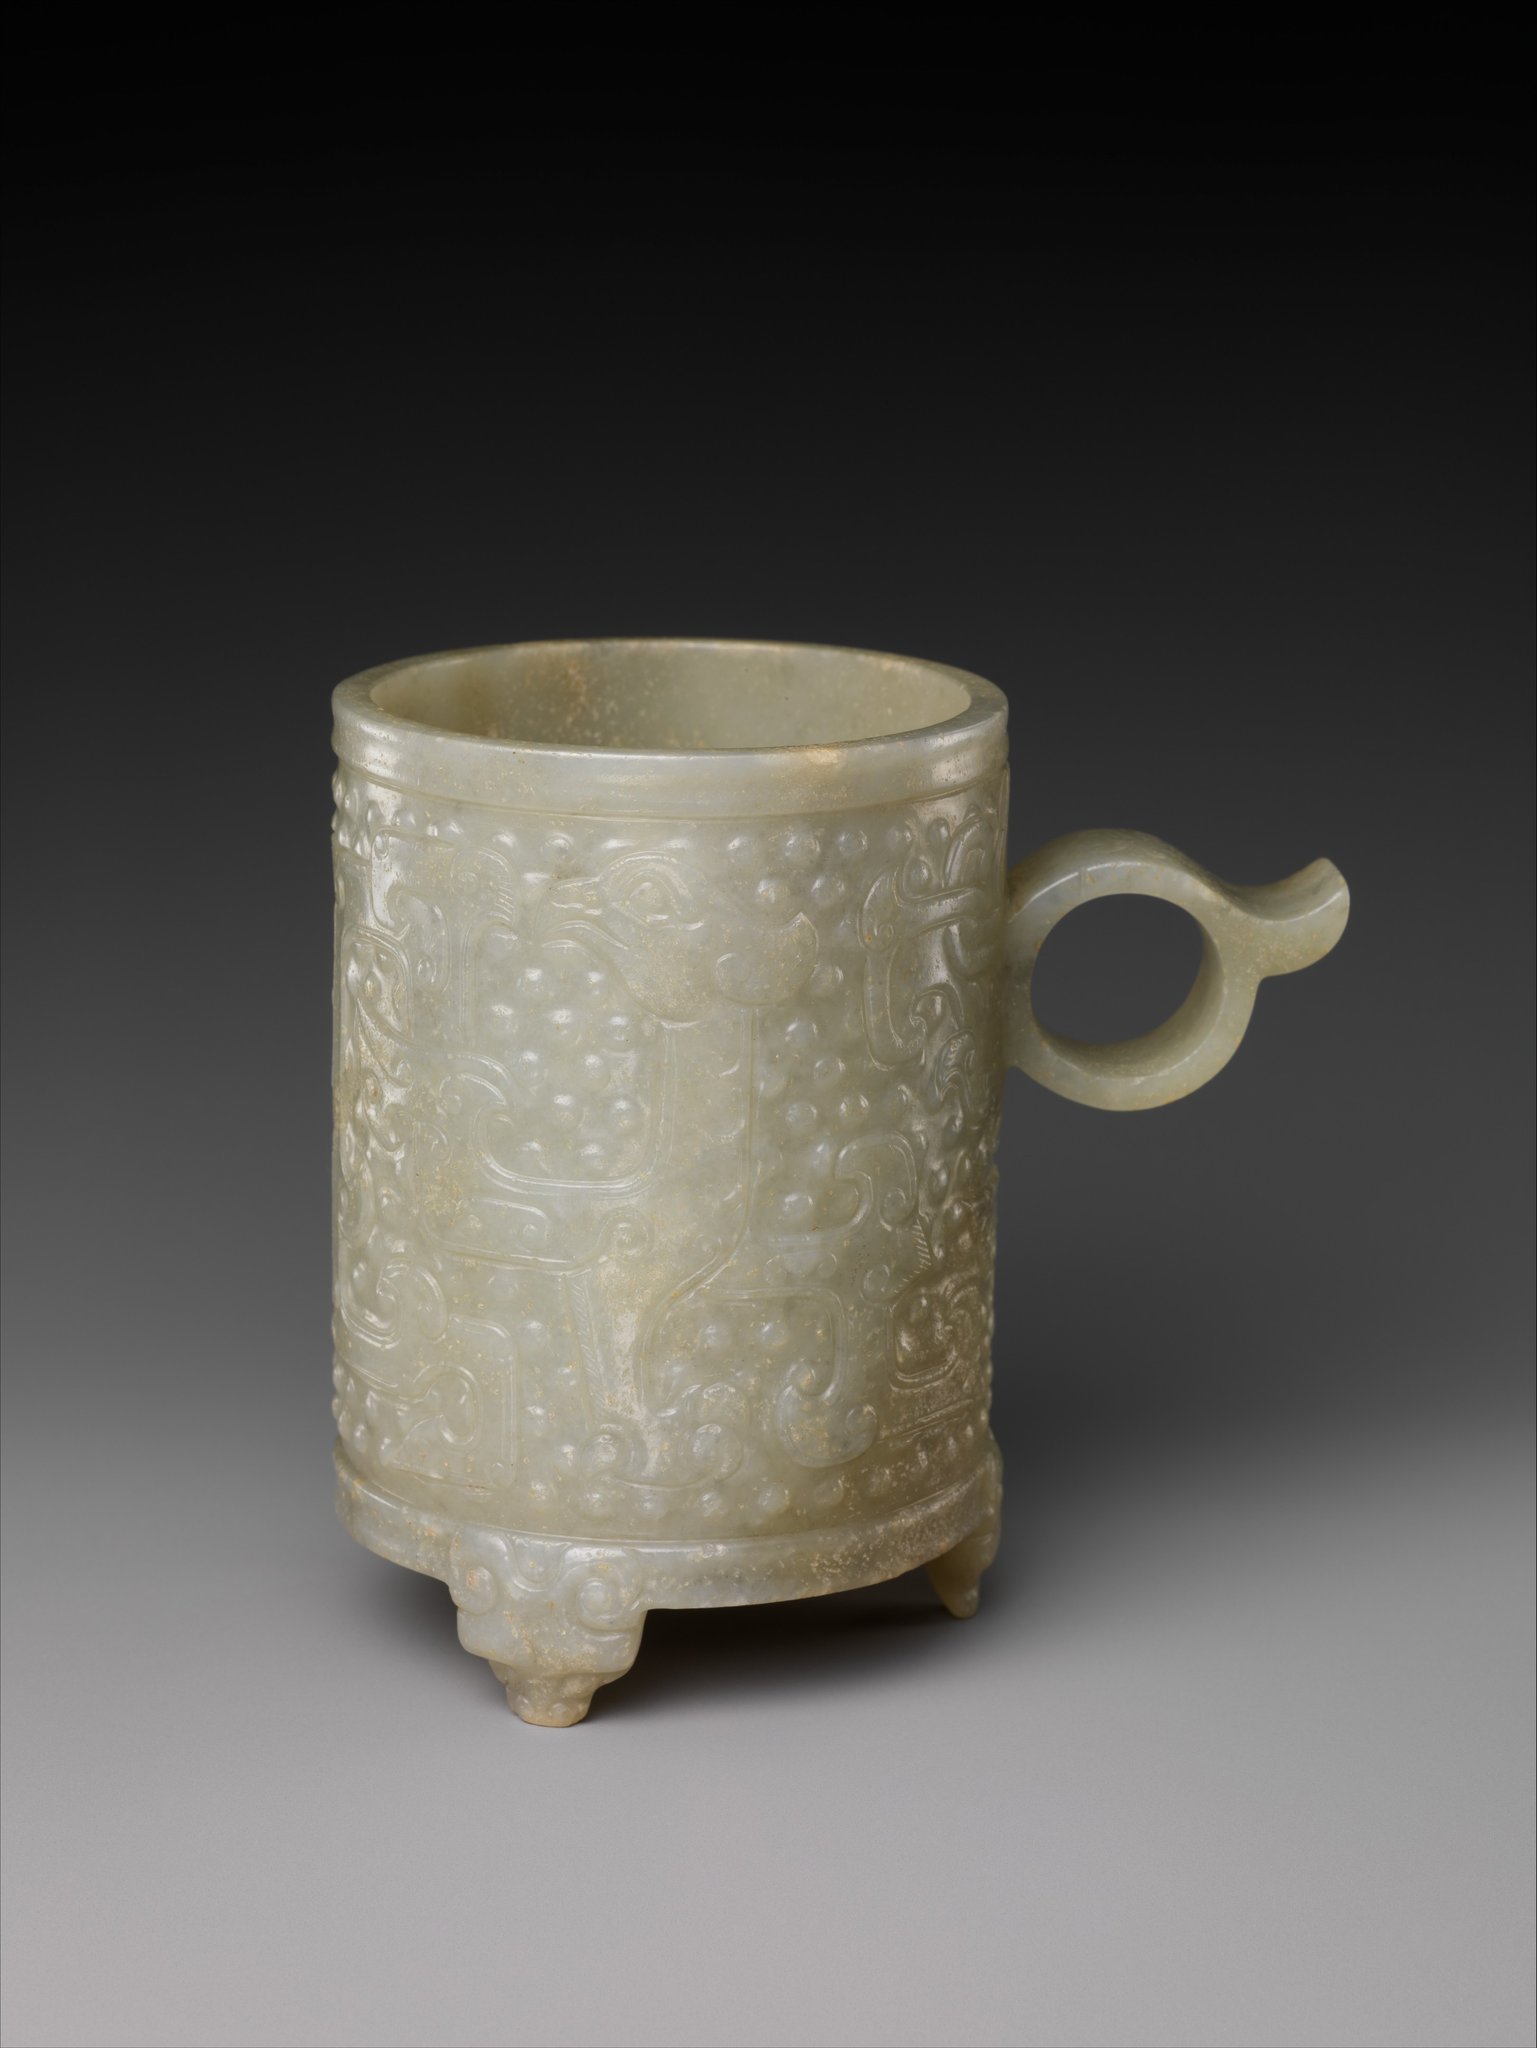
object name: cup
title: Archaic-style cup with ring handle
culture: chinese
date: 1601-1700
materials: jade